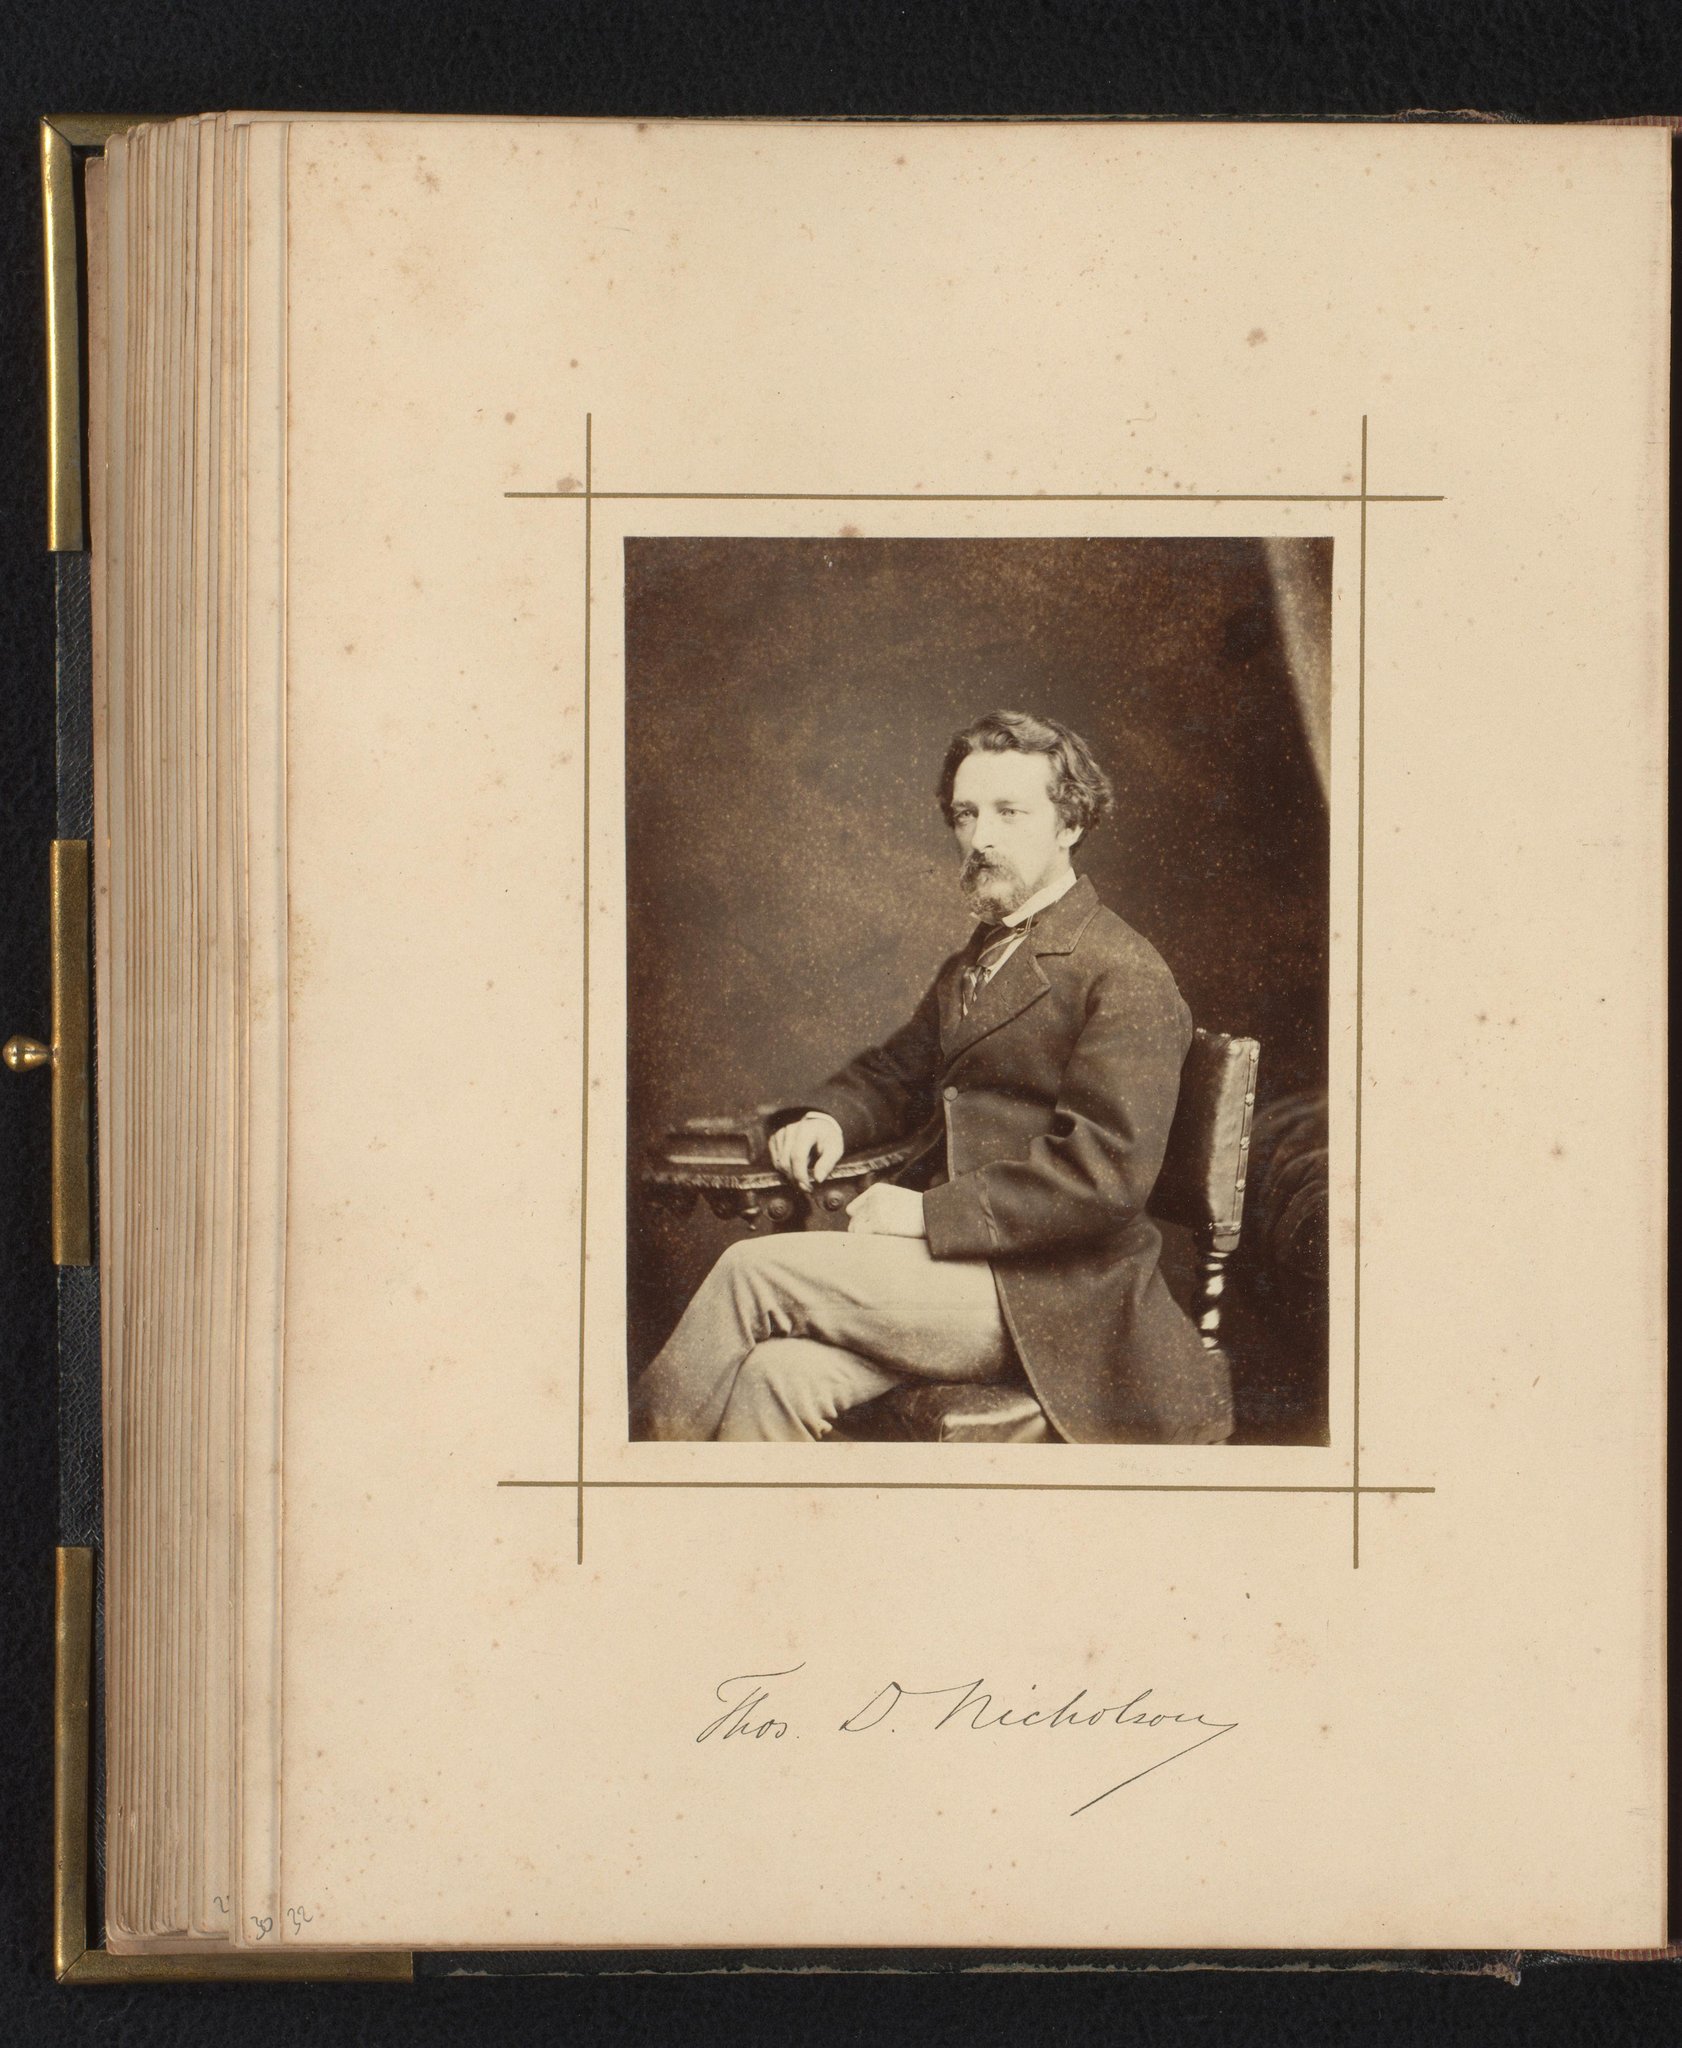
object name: page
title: Portret van Thomas D. Nicholson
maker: Anonymous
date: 1866-1871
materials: photographic support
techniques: albumen print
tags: sitting figure, historical persons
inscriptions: name: ‘Thos. D. Nicholson’